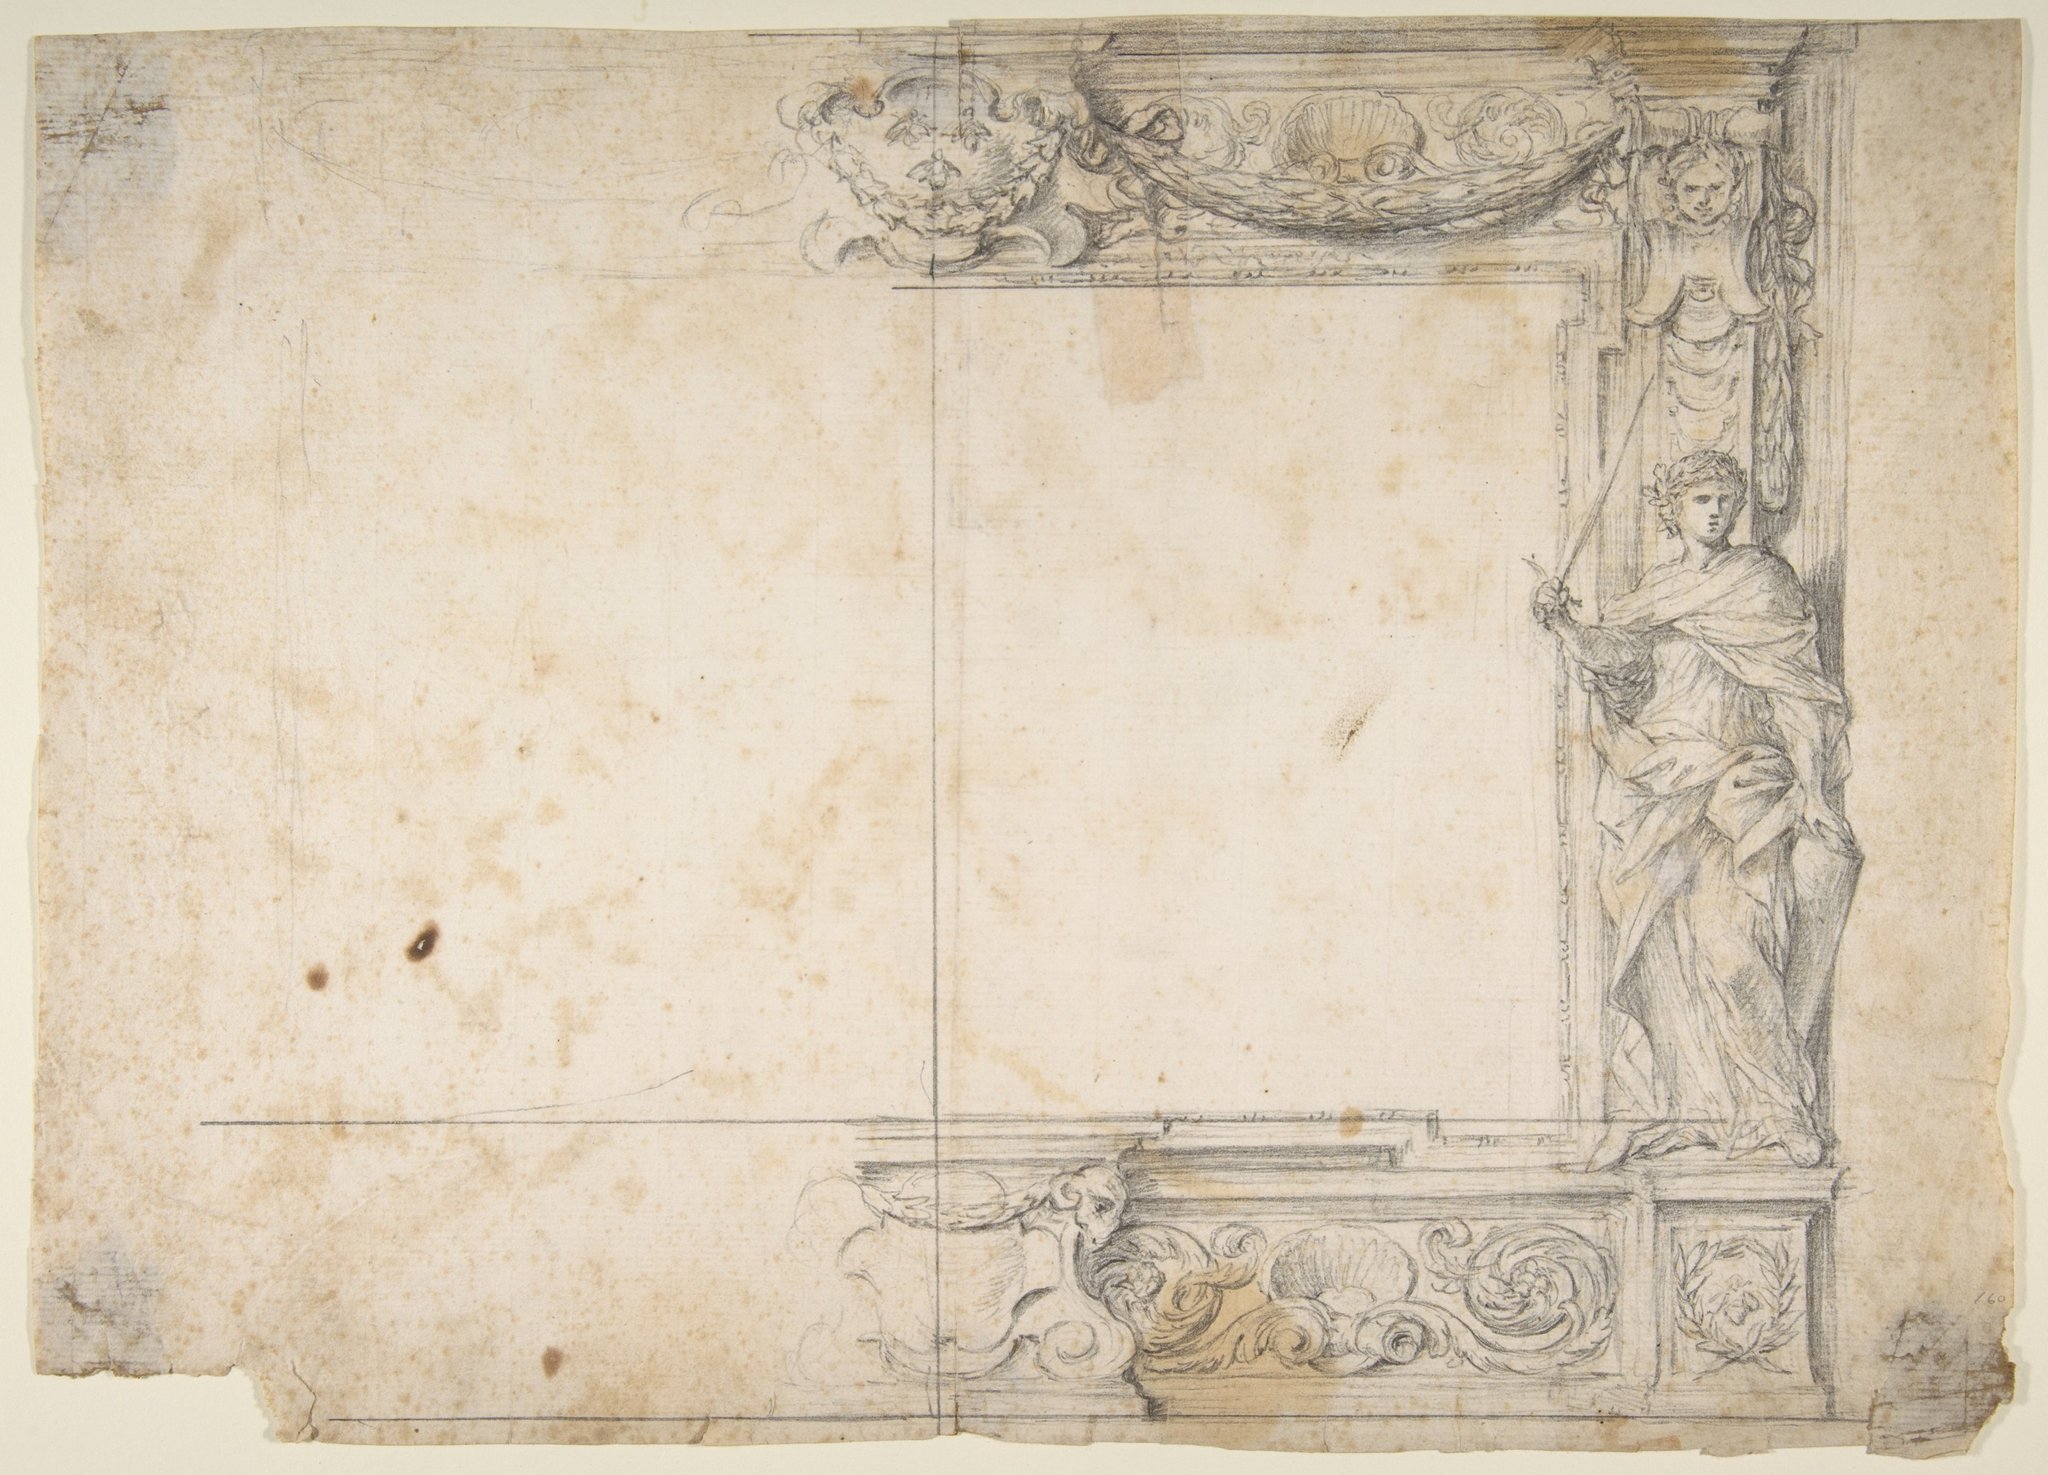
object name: drawing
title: One Half of a Design for a Frame of a Stage Proscenium, with a Figure of Justice at the Right, and the Barberini Arms in a Cartouche at the Top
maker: giovanni francesco romanelli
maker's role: artist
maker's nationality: italian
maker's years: 1610-1662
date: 1701-1800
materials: chalk, graphite, paper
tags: swords,cartouches,men